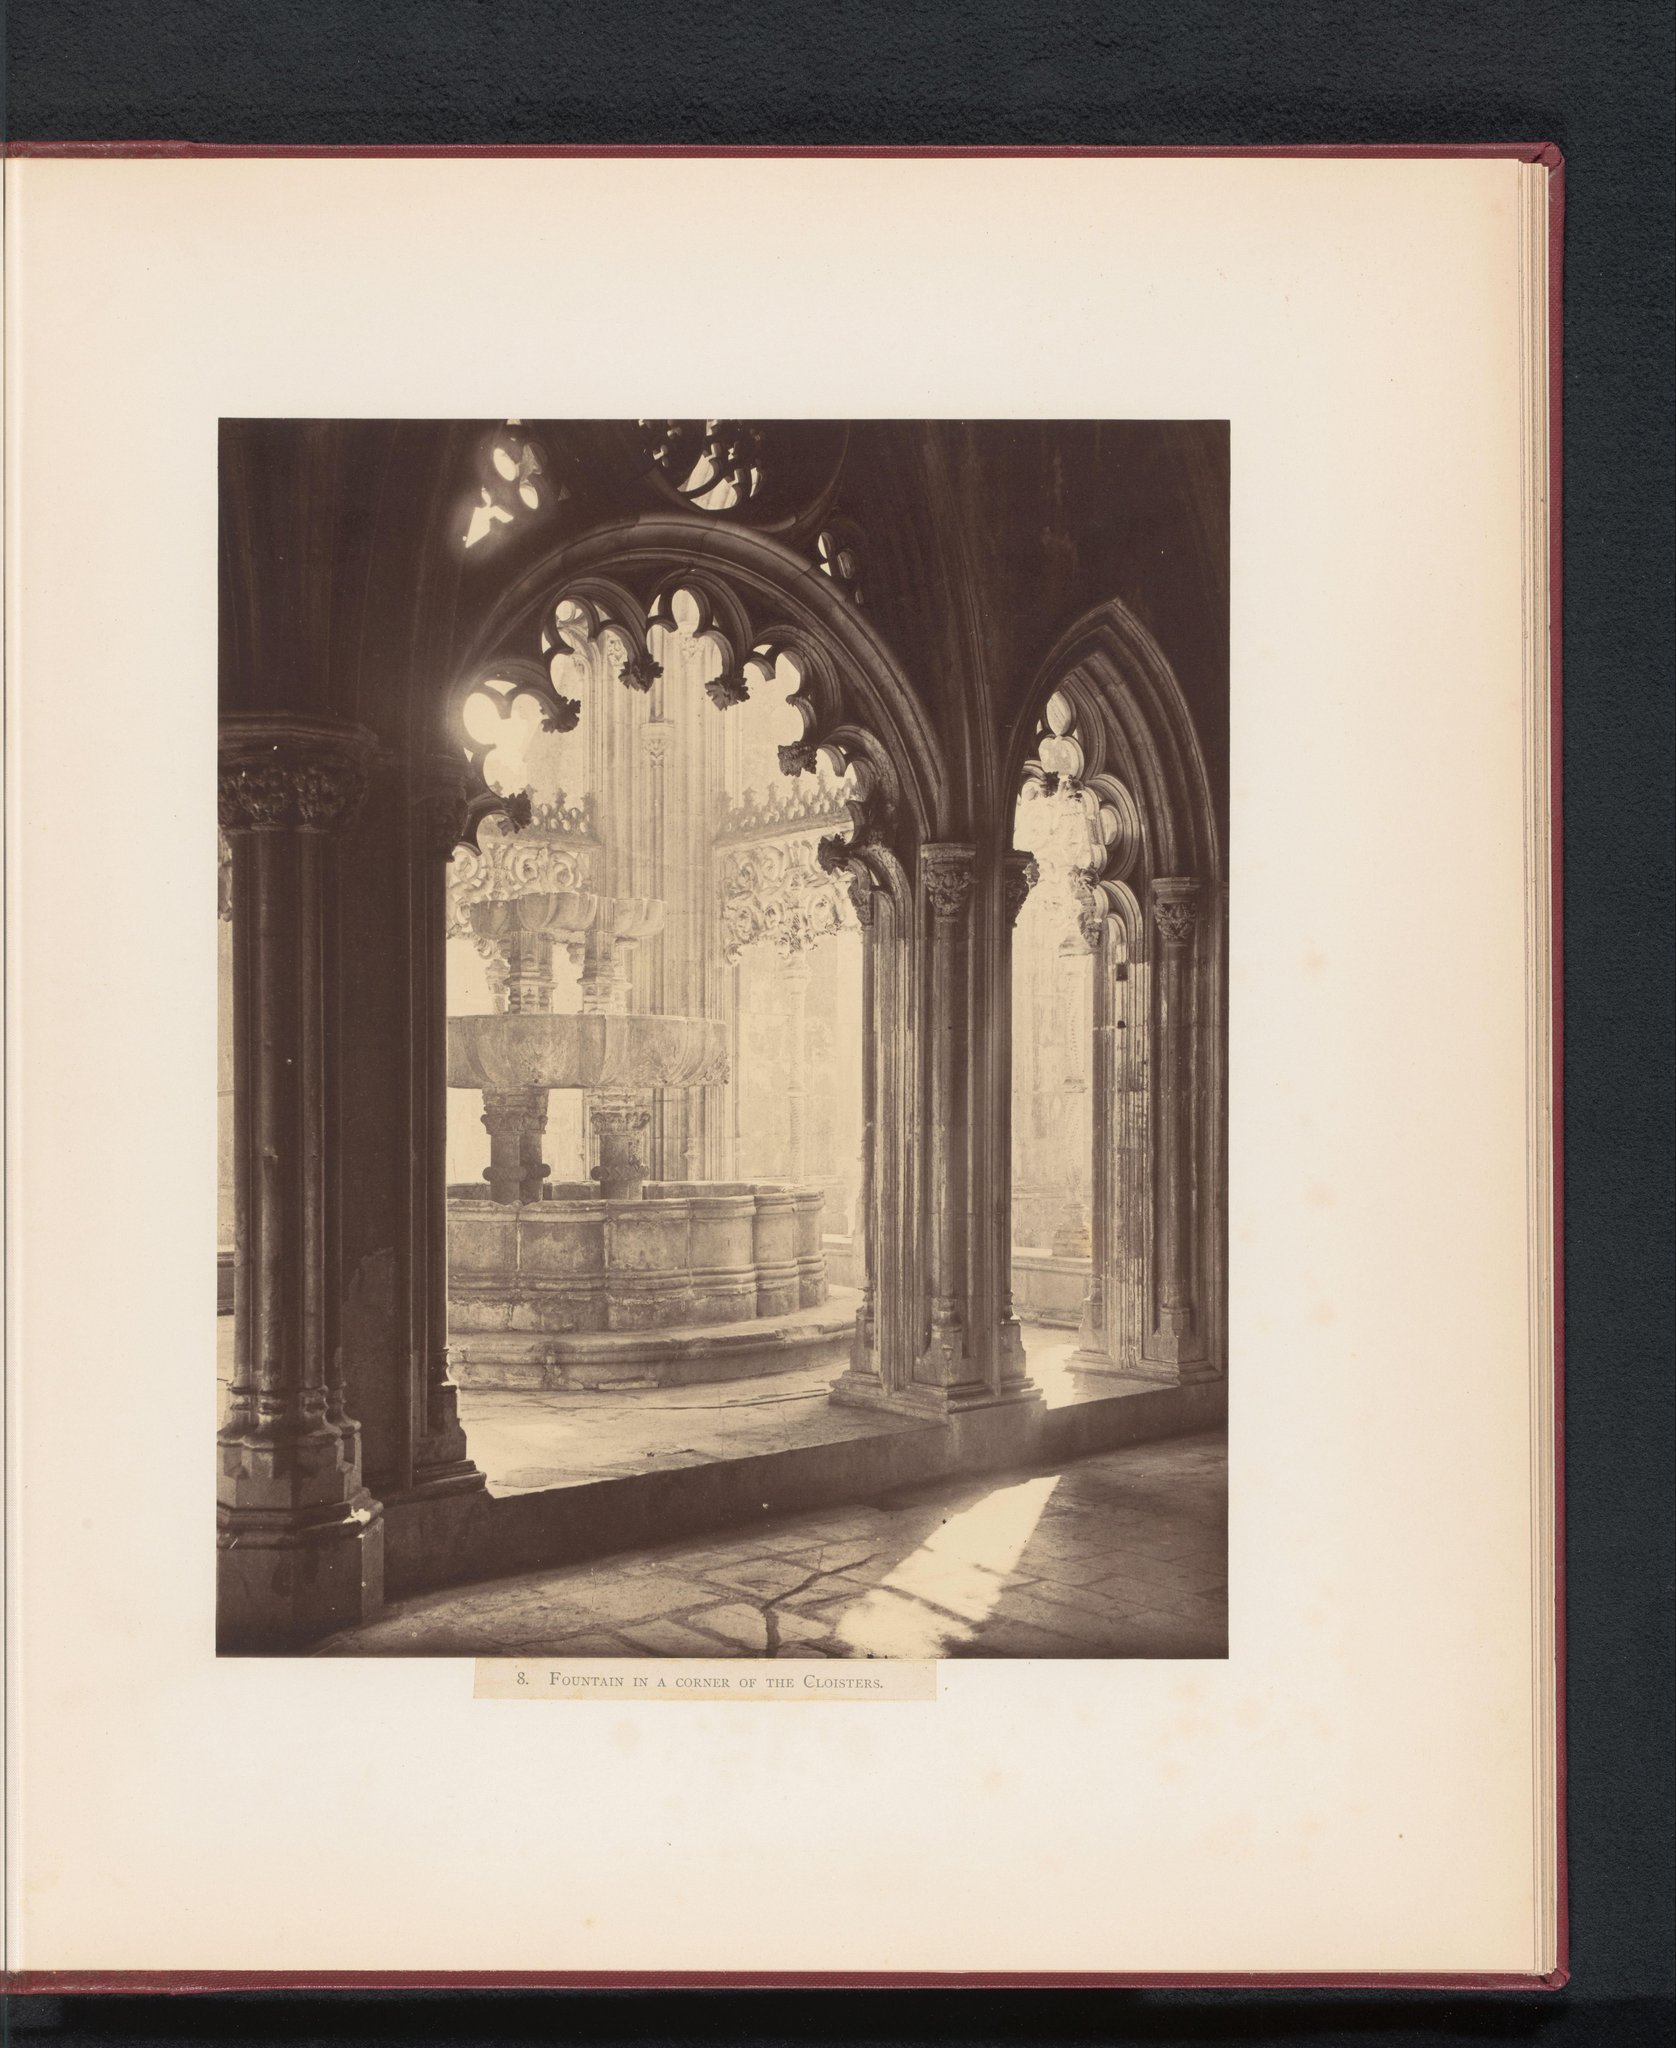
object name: photograph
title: Fountain in a Corner of the Cloisters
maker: charles thurston thompson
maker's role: fotograaf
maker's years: 1816-1868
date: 1863-1868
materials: photographic support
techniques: albumen print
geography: batalha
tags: cloisters ~ monastery, ornamental fountain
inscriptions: number: ‘8.’